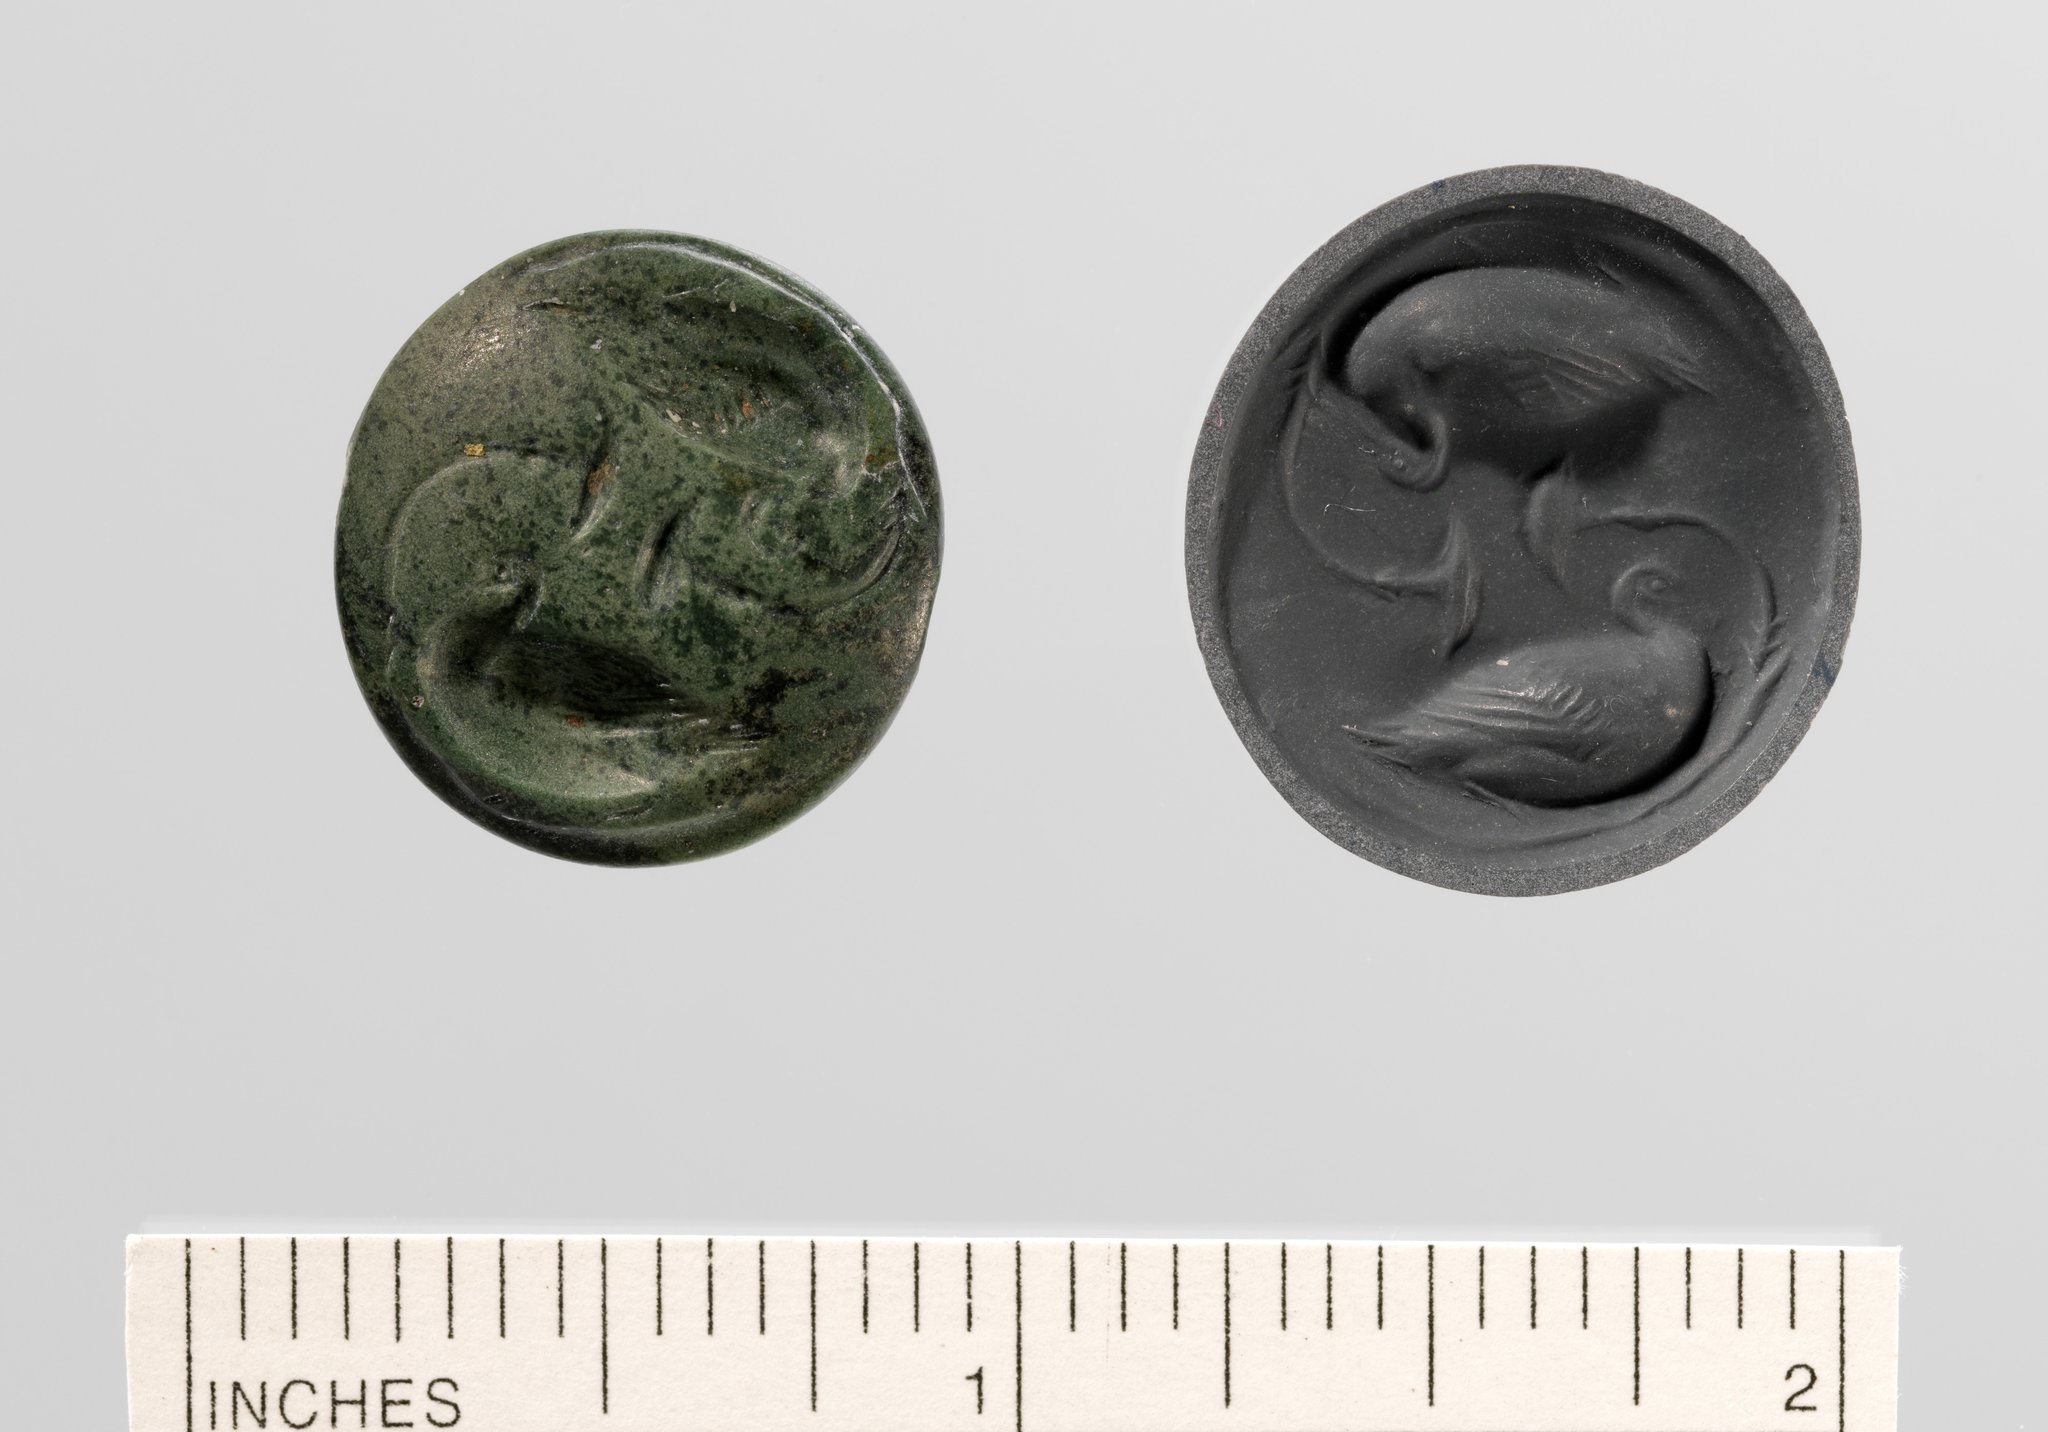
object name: seal, lentoid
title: Serpentine Lentoid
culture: minoan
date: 1600-1450 BCE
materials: stone